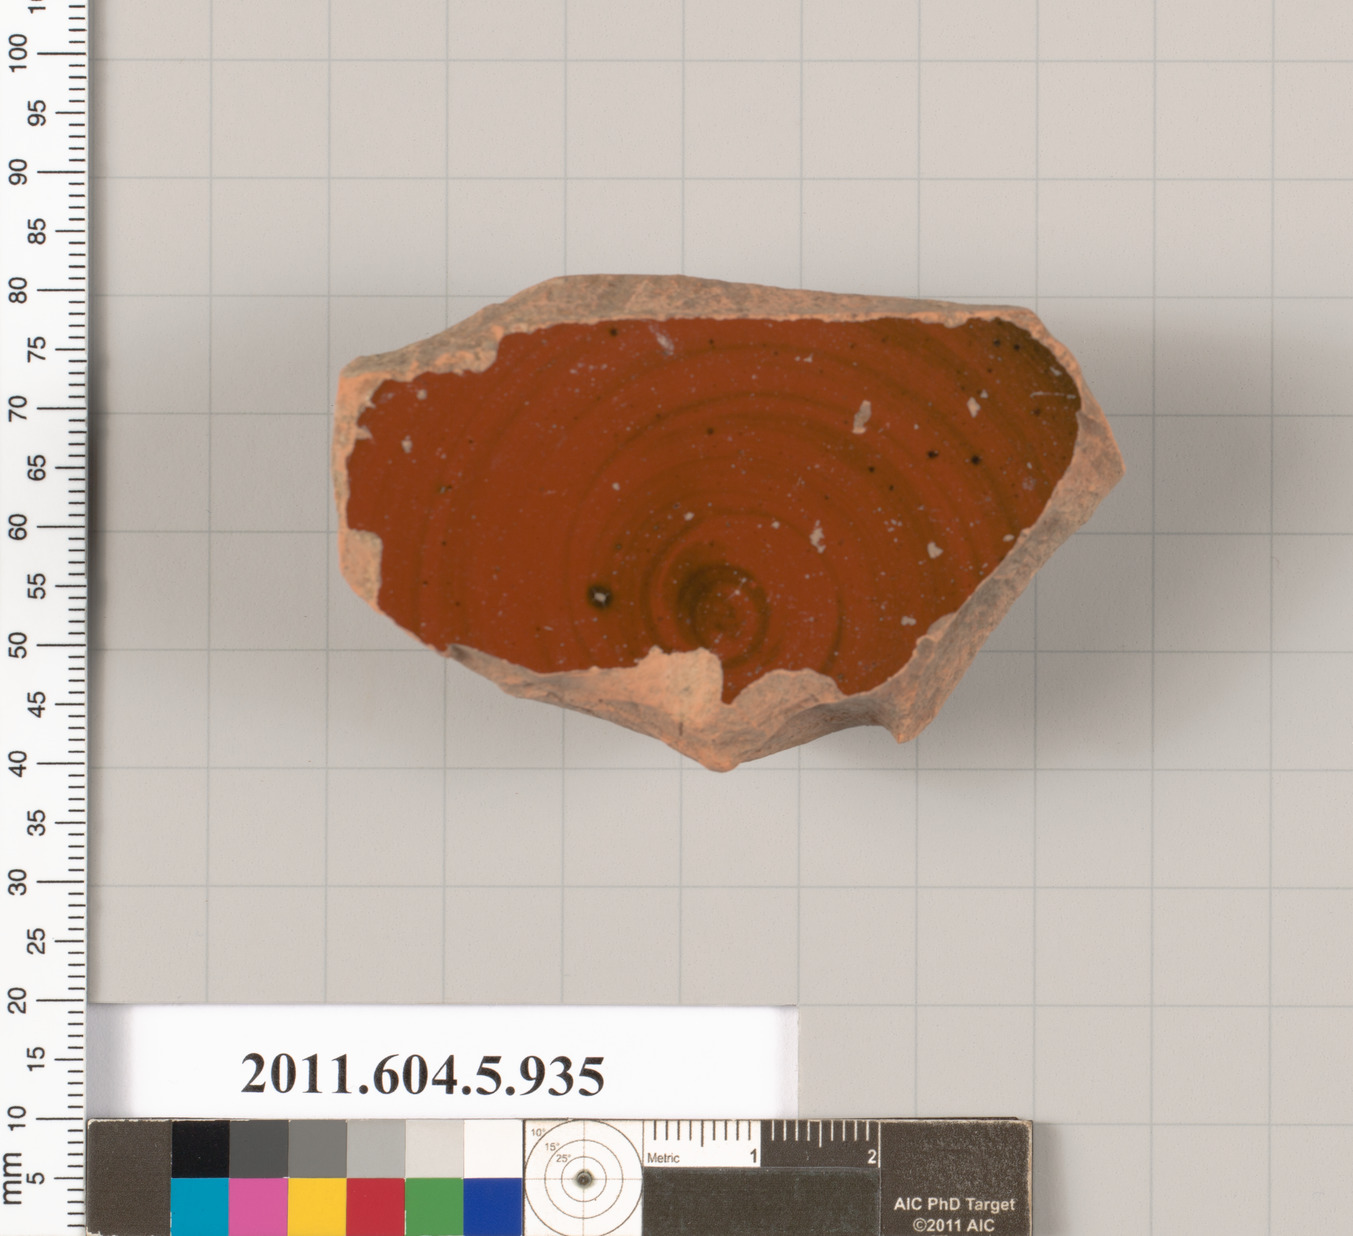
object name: kylix fragment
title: Terracotta fragment of a kylix (drinking cup)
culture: greek, attic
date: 600-401 BCE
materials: terracotta